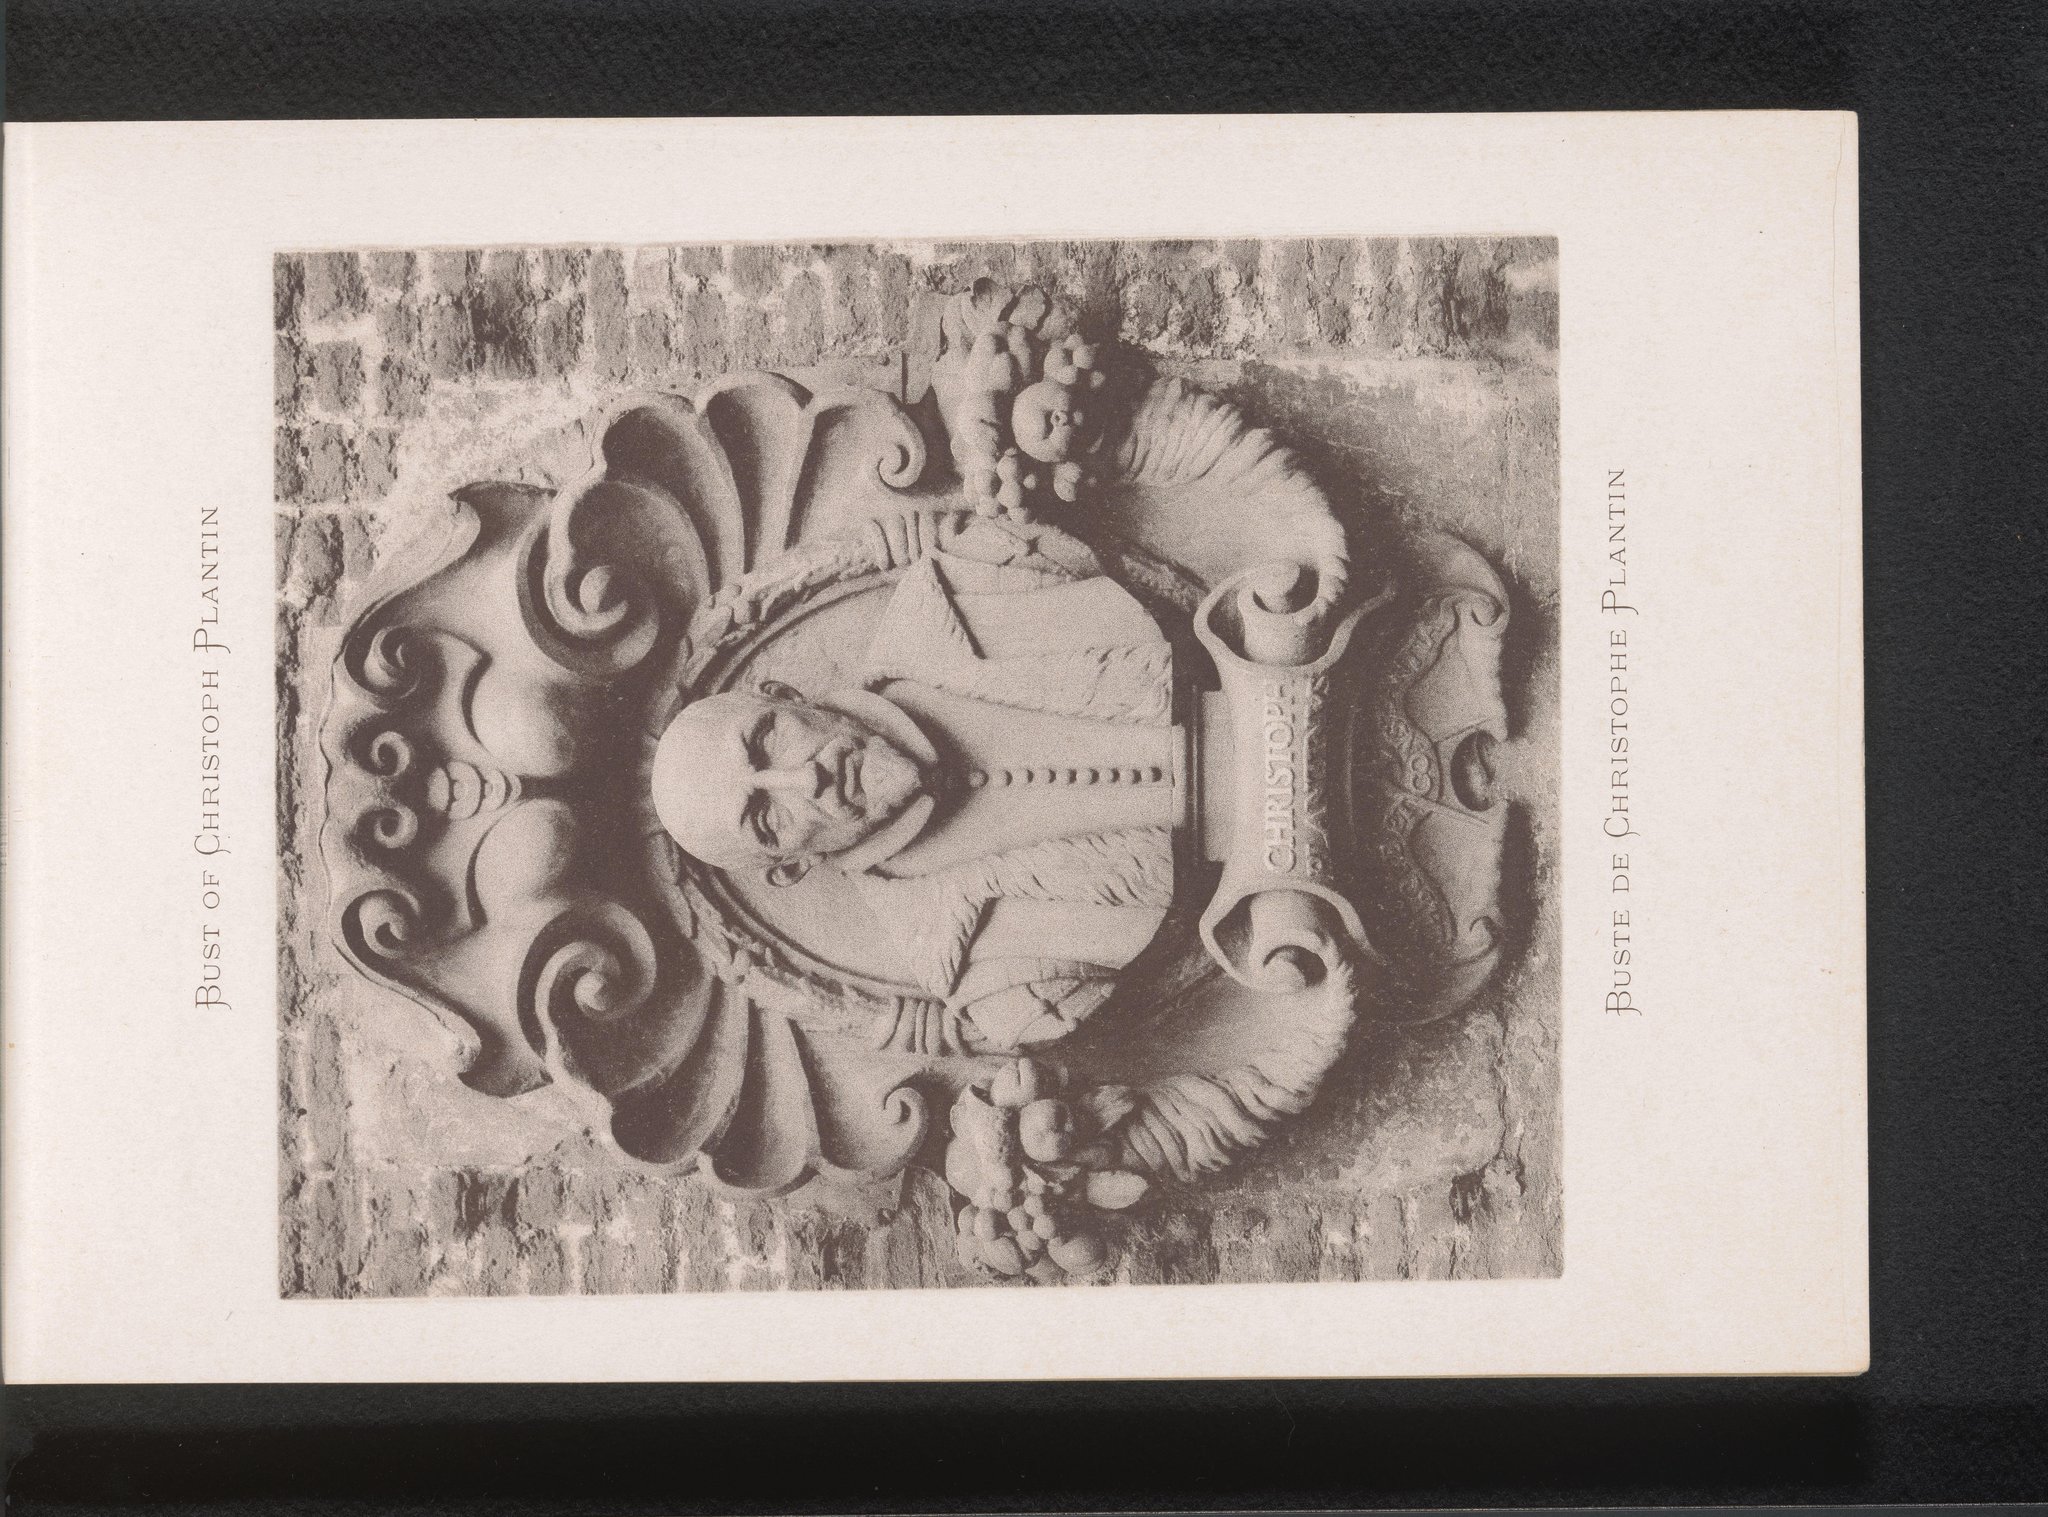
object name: photomechanical print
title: Buste de Christophe Plantin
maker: Anonymous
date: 1892-1897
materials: paper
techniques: photograph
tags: publisher, christoffel plantijn, chest, bust, sculpture